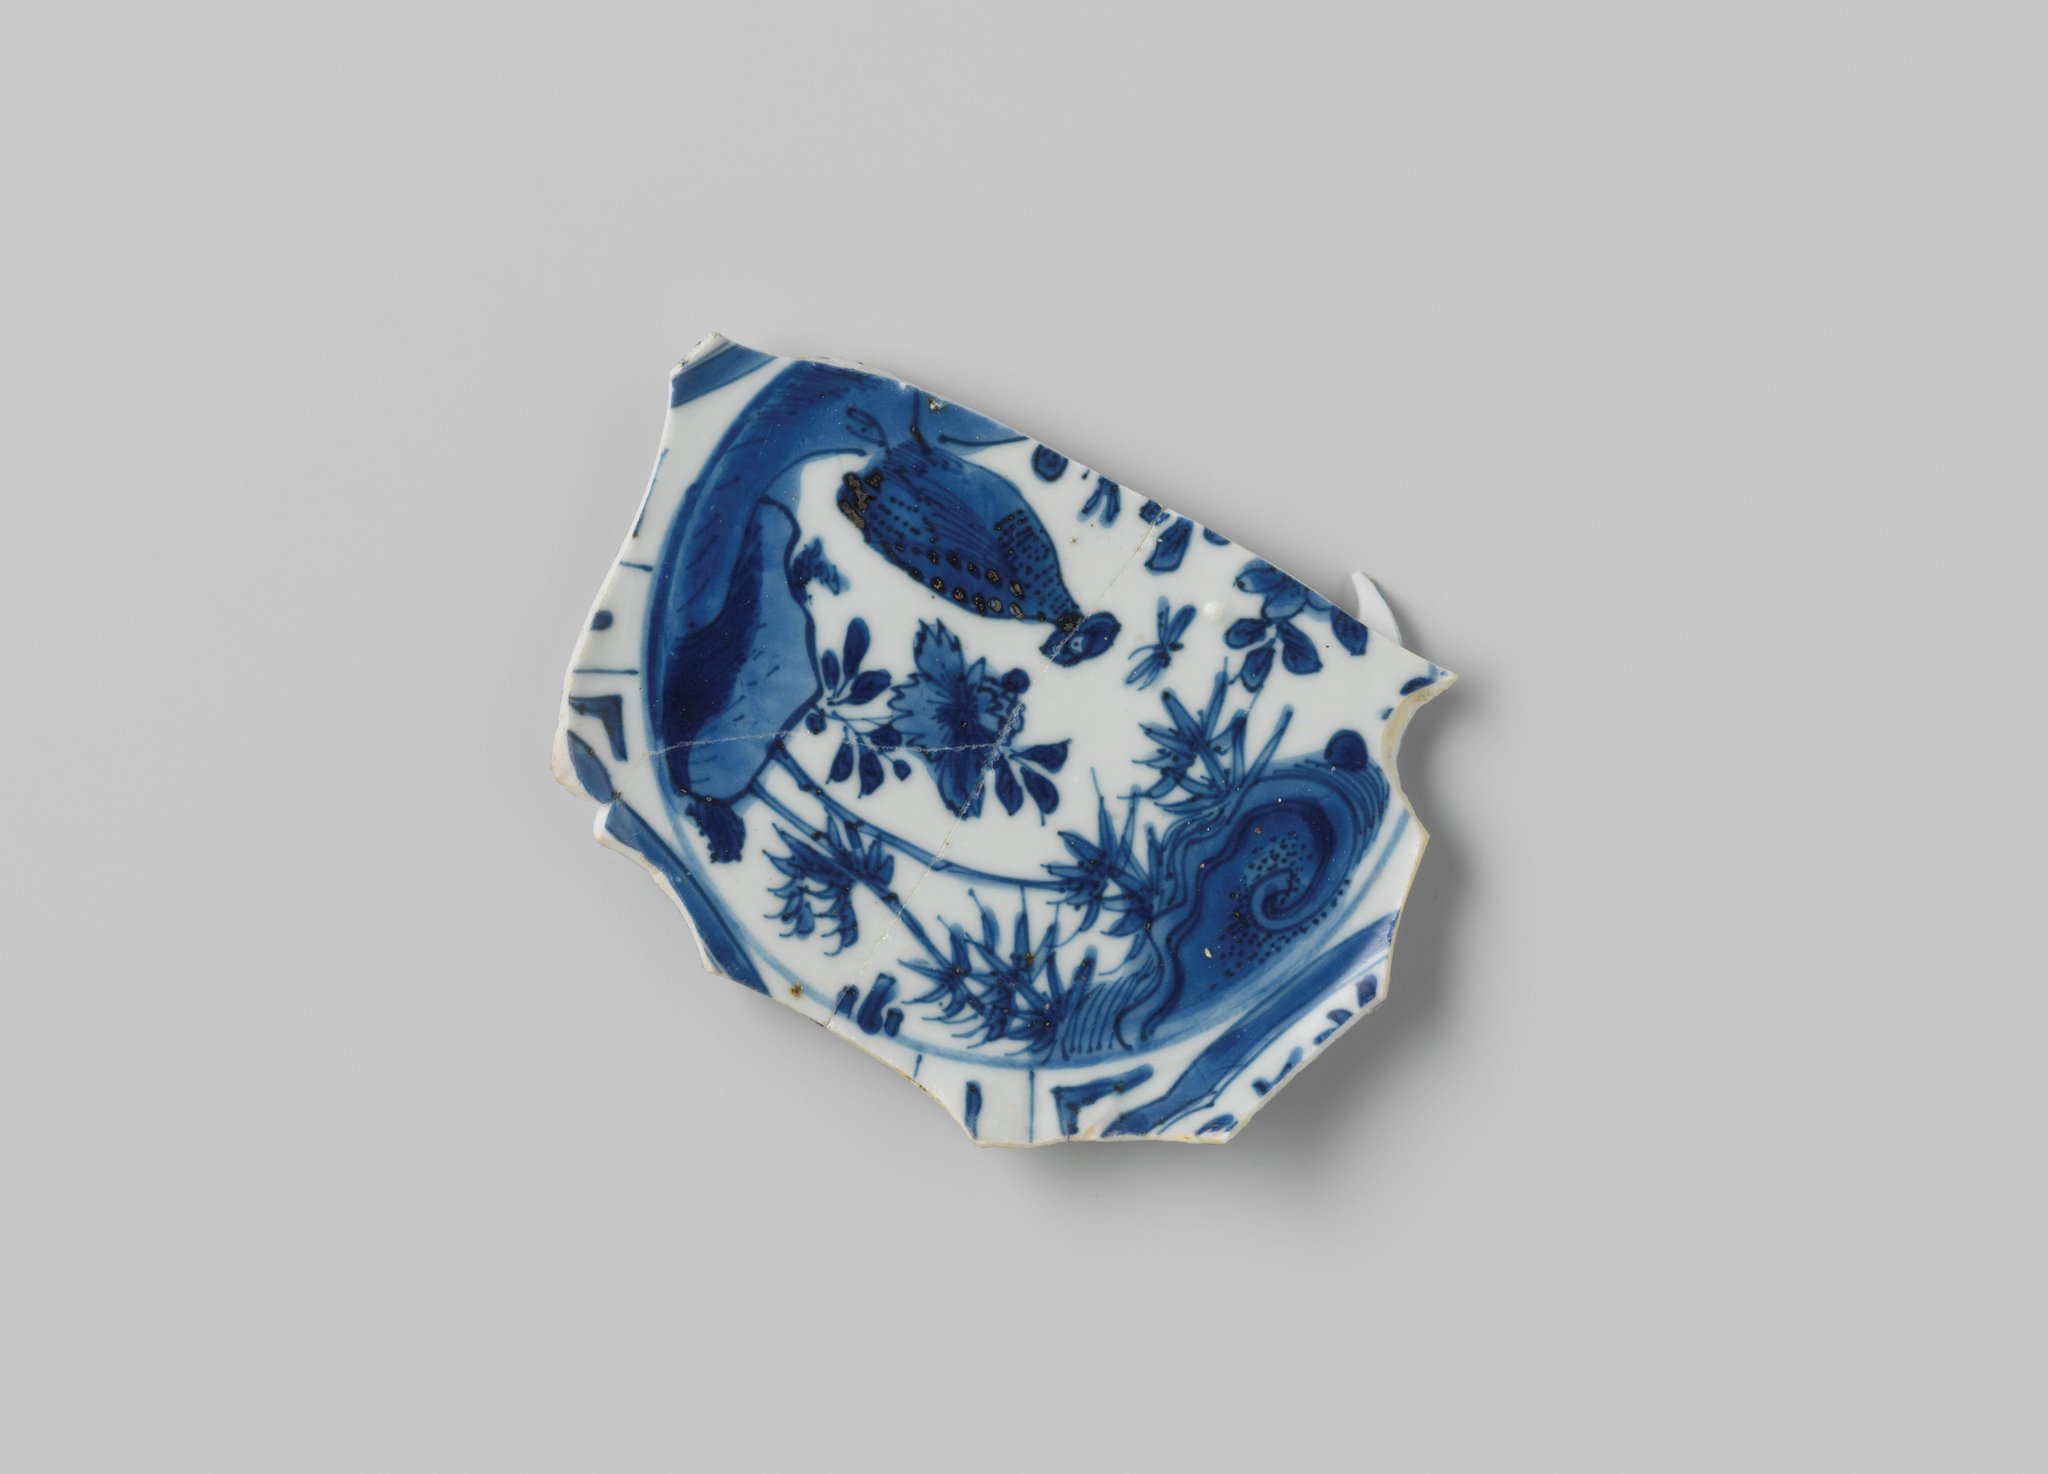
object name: deep dish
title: Fragment diep bord uit V.O.C.-schip de 'Witte Leeuw'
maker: Anonymous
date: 1613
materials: bone china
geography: jingdezhen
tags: verenigde oostindische compagnie, sint-helena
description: A bowl with a flattened rim. Taotie mask and/or borders with diaper patterns. A central decoration of a grasshopper on a rock next to a peony. Panels decorated with flowers and fruits.